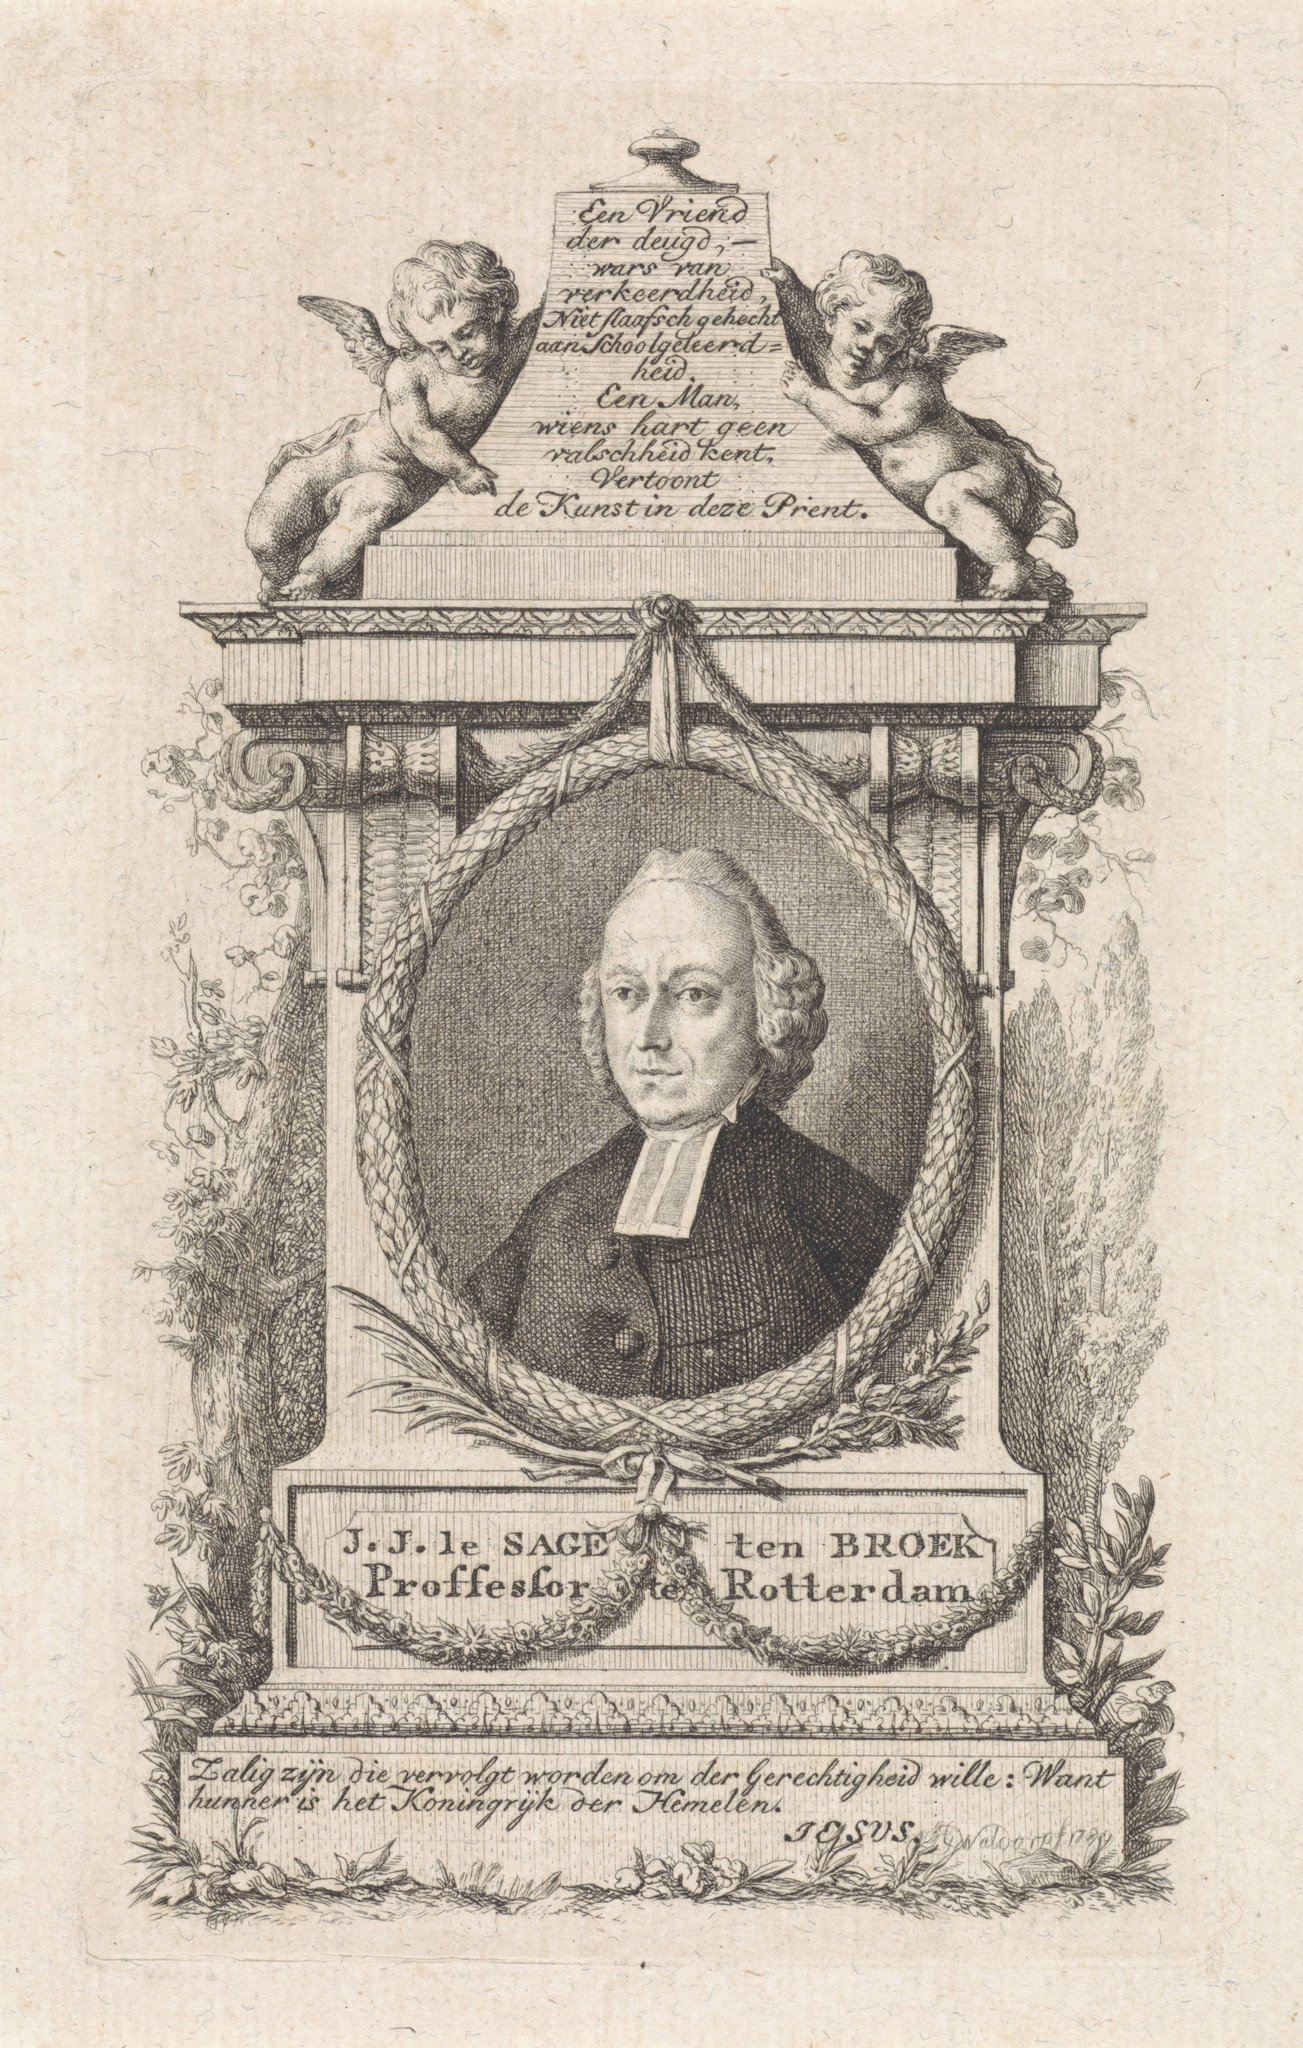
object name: print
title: Portret van predikant Johan Jacob le Sage ten Broek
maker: jan gerard waldorp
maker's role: draughtsman, print maker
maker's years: 1740-1808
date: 1789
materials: paper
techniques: engraving, etching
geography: amsterdam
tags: the hague, other memorial structures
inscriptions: collector's mark: Lugt 2228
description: Gedenkzuil met het portet van predikant Johan Jacob le Sage ten Broek. Op de bovenkant van het monument een elfregelig lofdicht in het Nederlands, geflankeerd door twee putti. Op de piëdestal een tweeregelig Bijbelcitaat uit de Bergrede in het Nederlands.